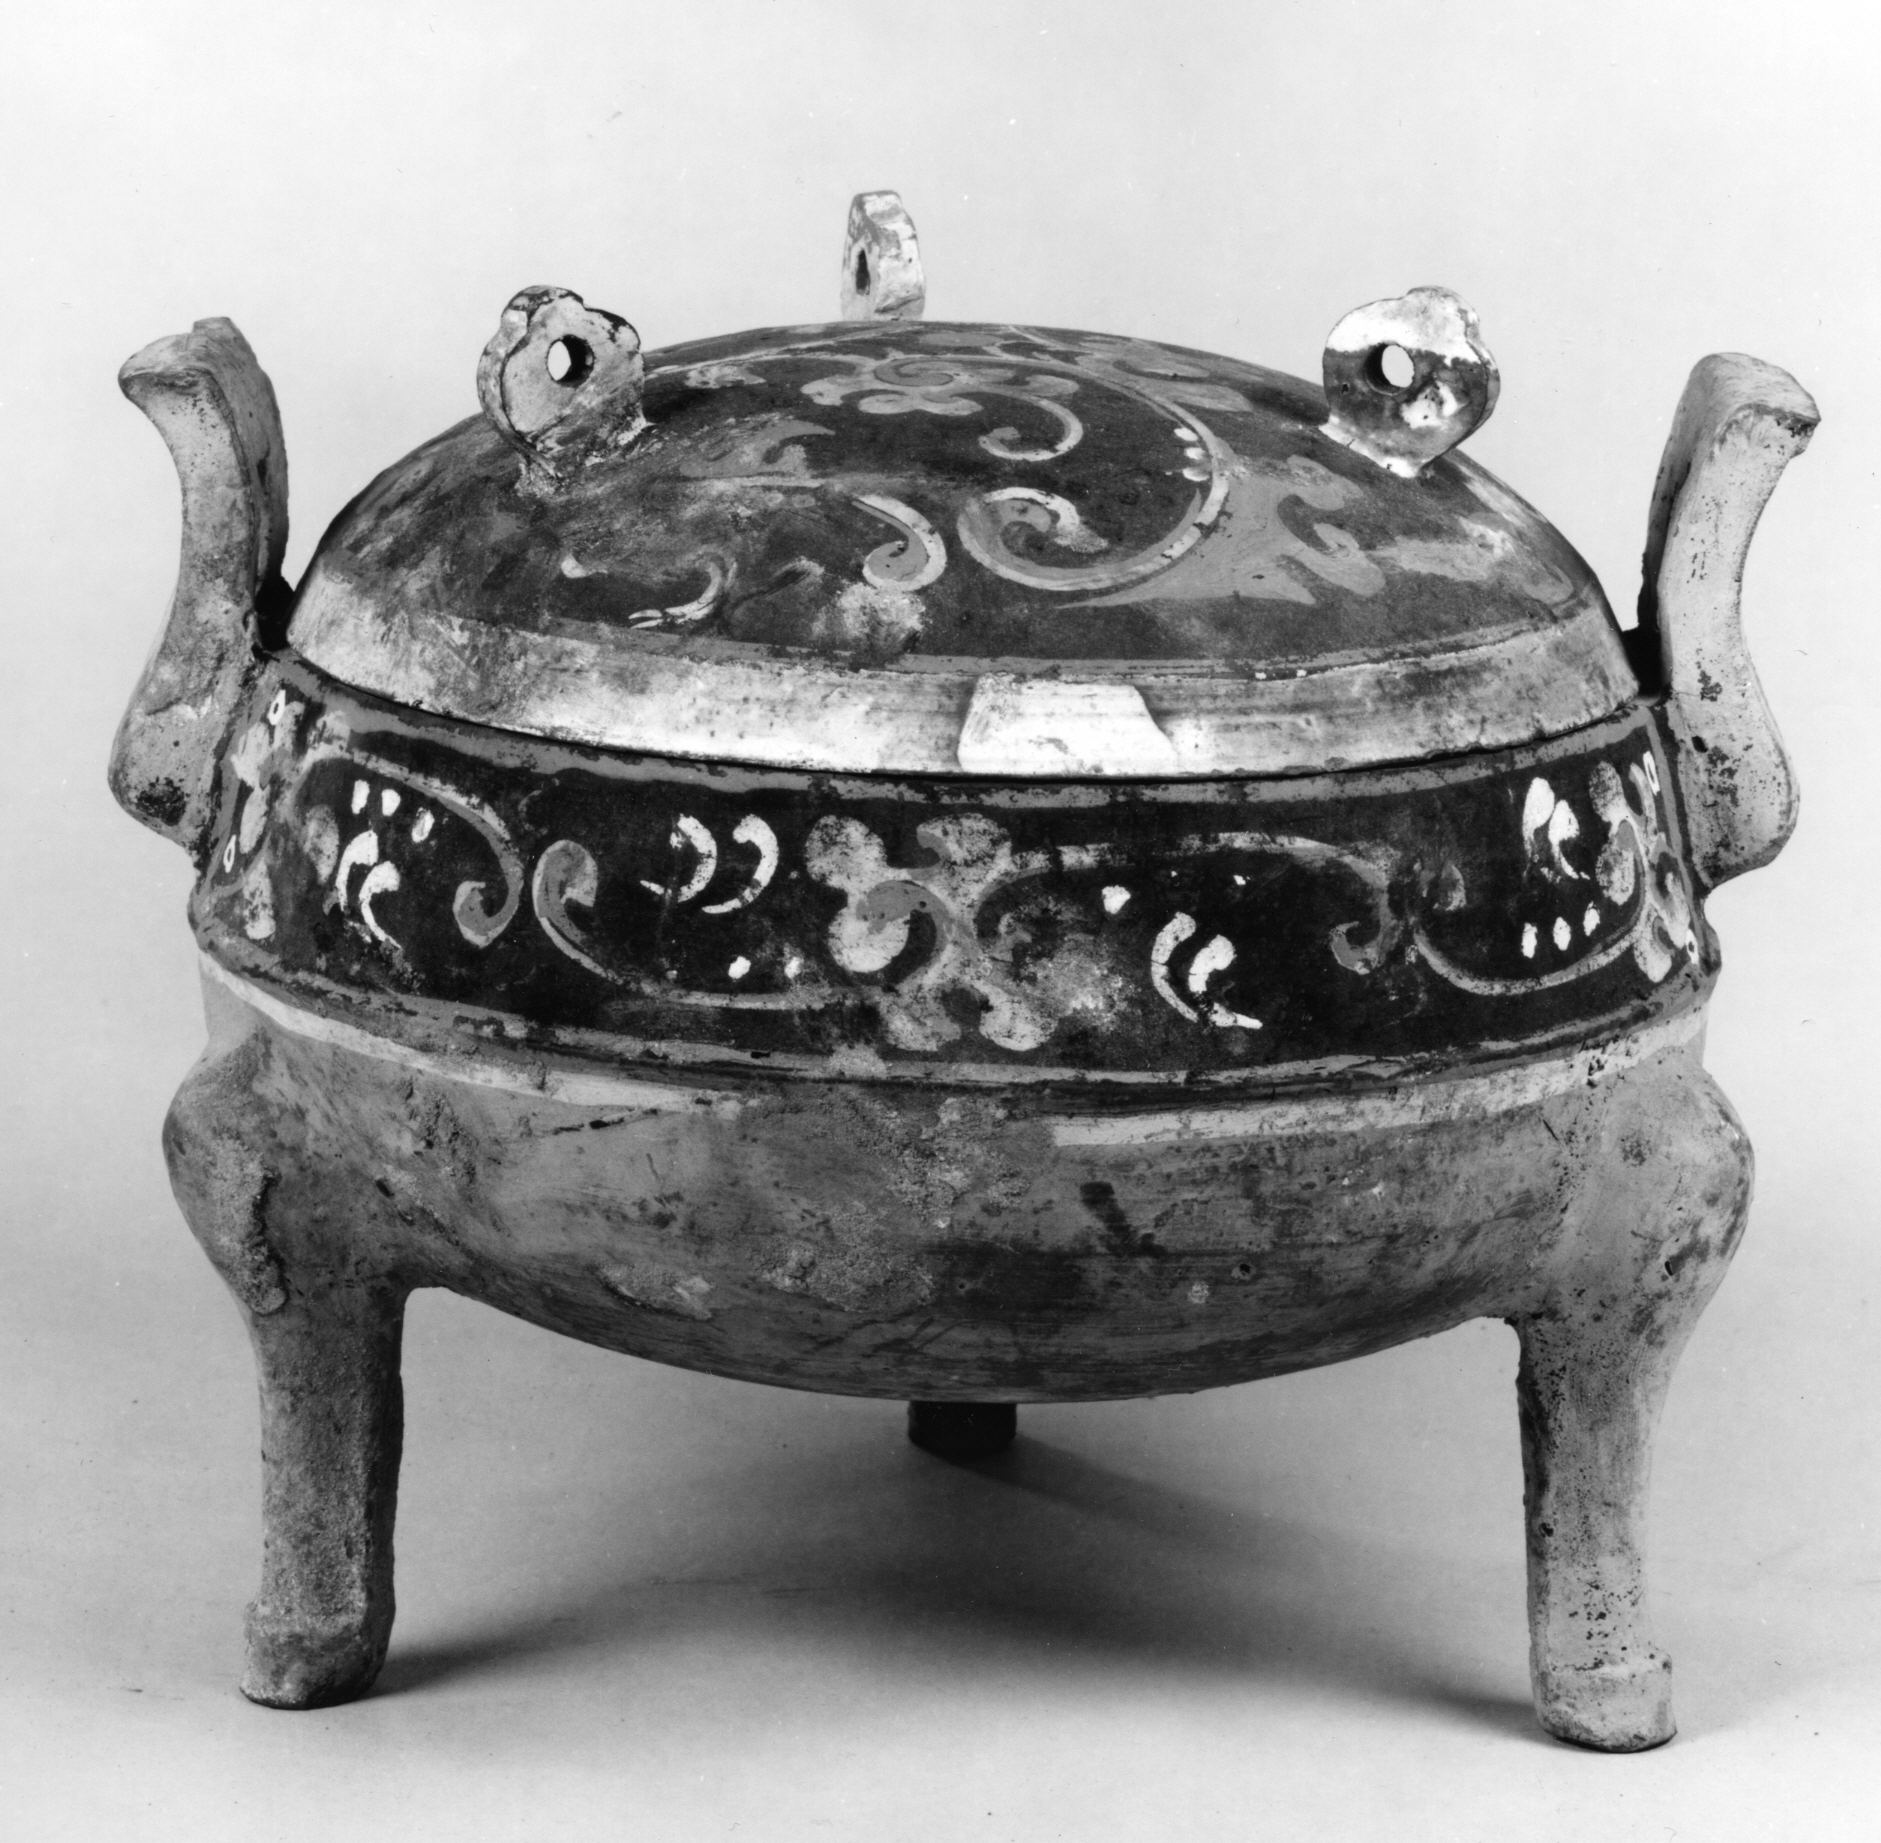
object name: cauldron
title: Tripod Cauldron (Ding)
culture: chinese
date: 206 BCE-9 CE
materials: earthenware, pigment